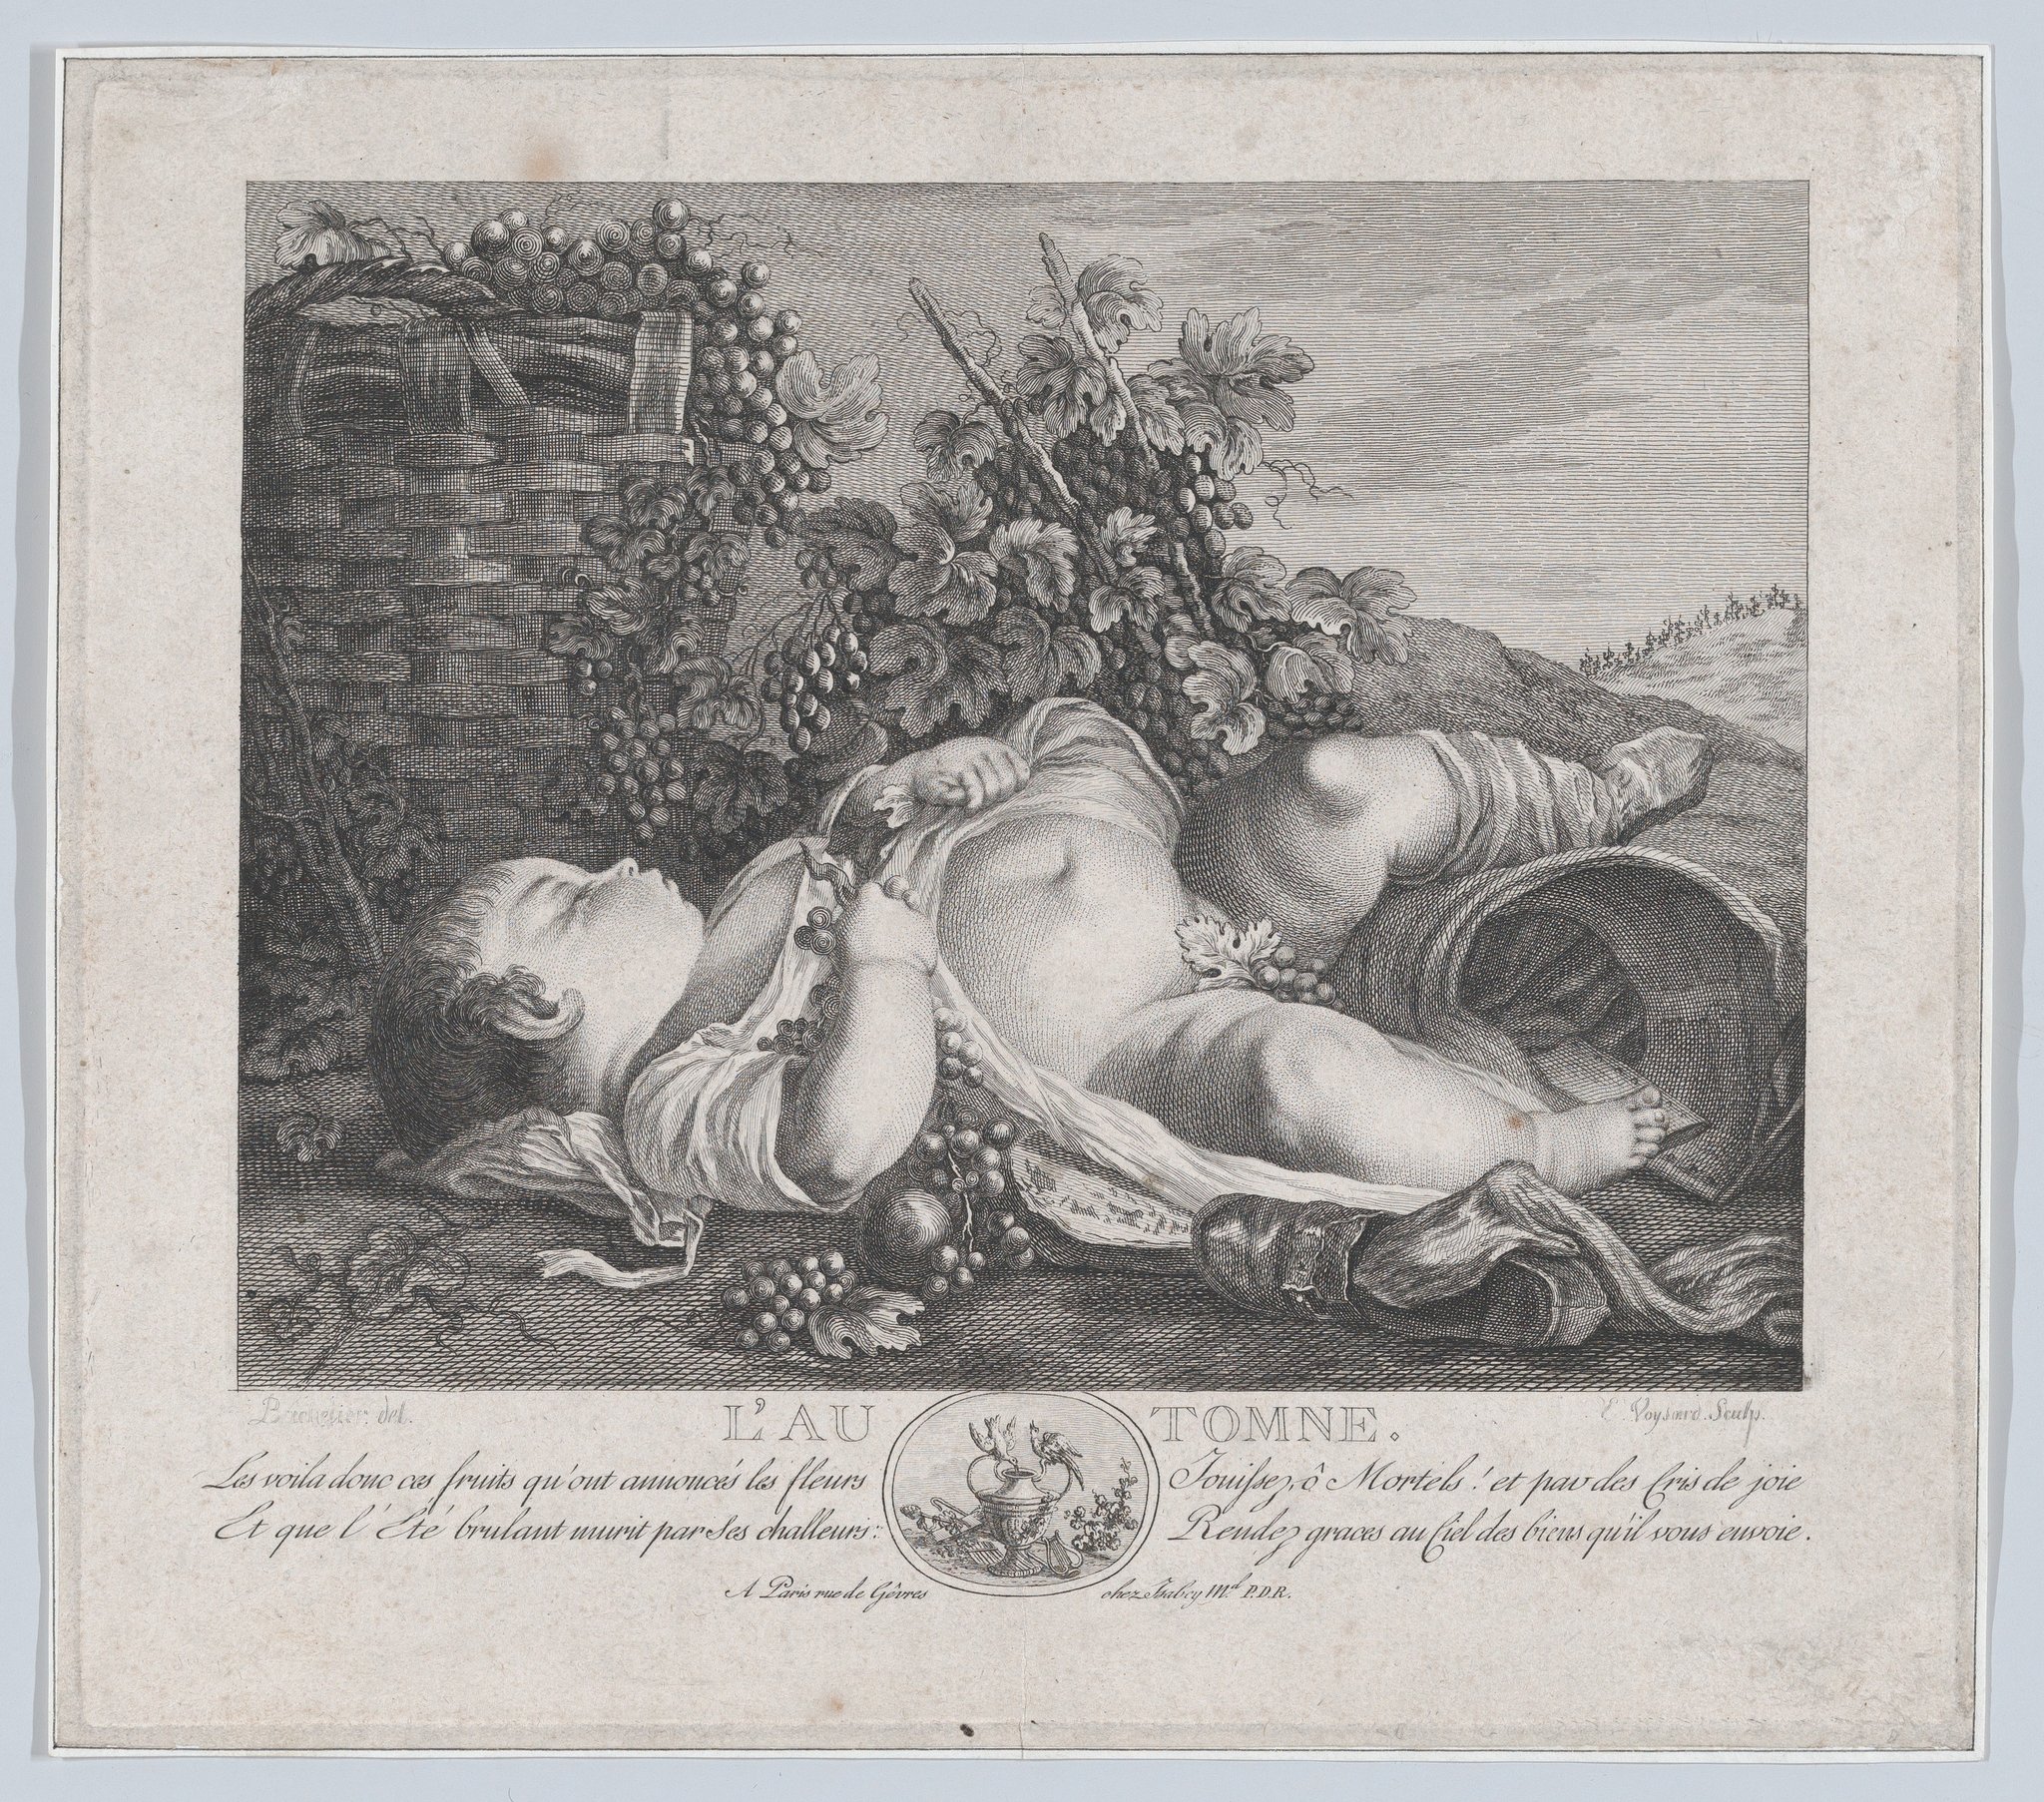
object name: print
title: Autumn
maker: etienne claude voysard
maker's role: engraver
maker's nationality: french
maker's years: 1746-1812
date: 1766-1812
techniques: engraving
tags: grapes,sleeping,infants